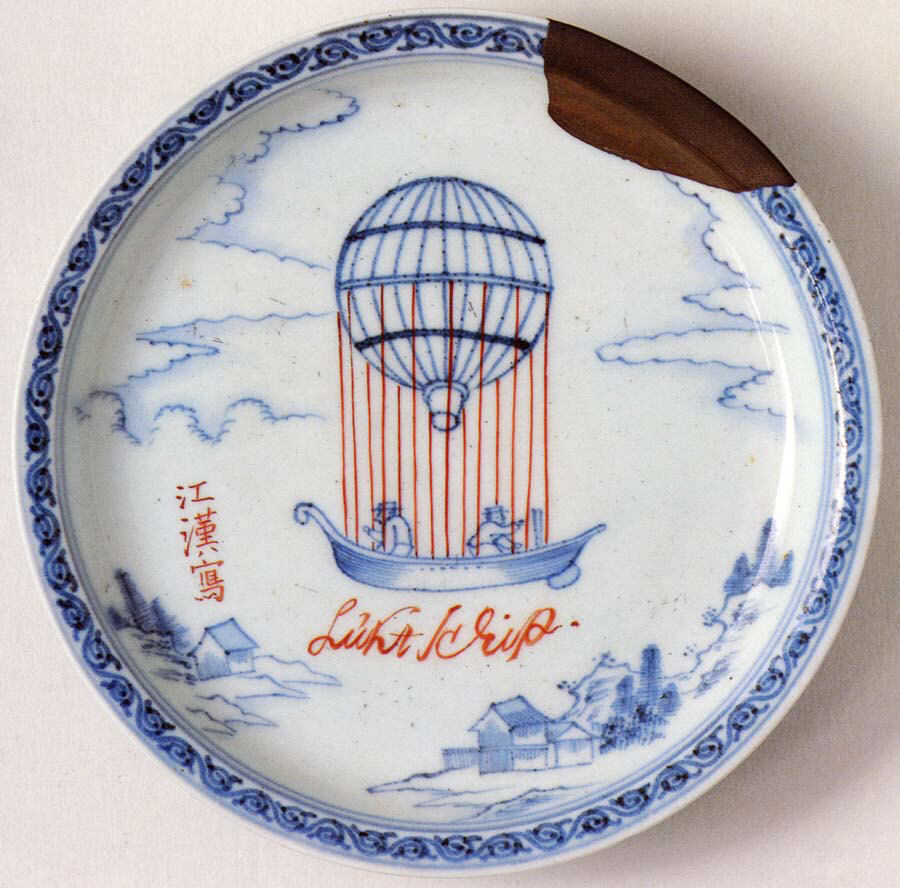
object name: dish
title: Dish with Design of Ascending Balloon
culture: japanese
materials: enamel, porcelain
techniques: overglaze, underglaze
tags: hot air balloons